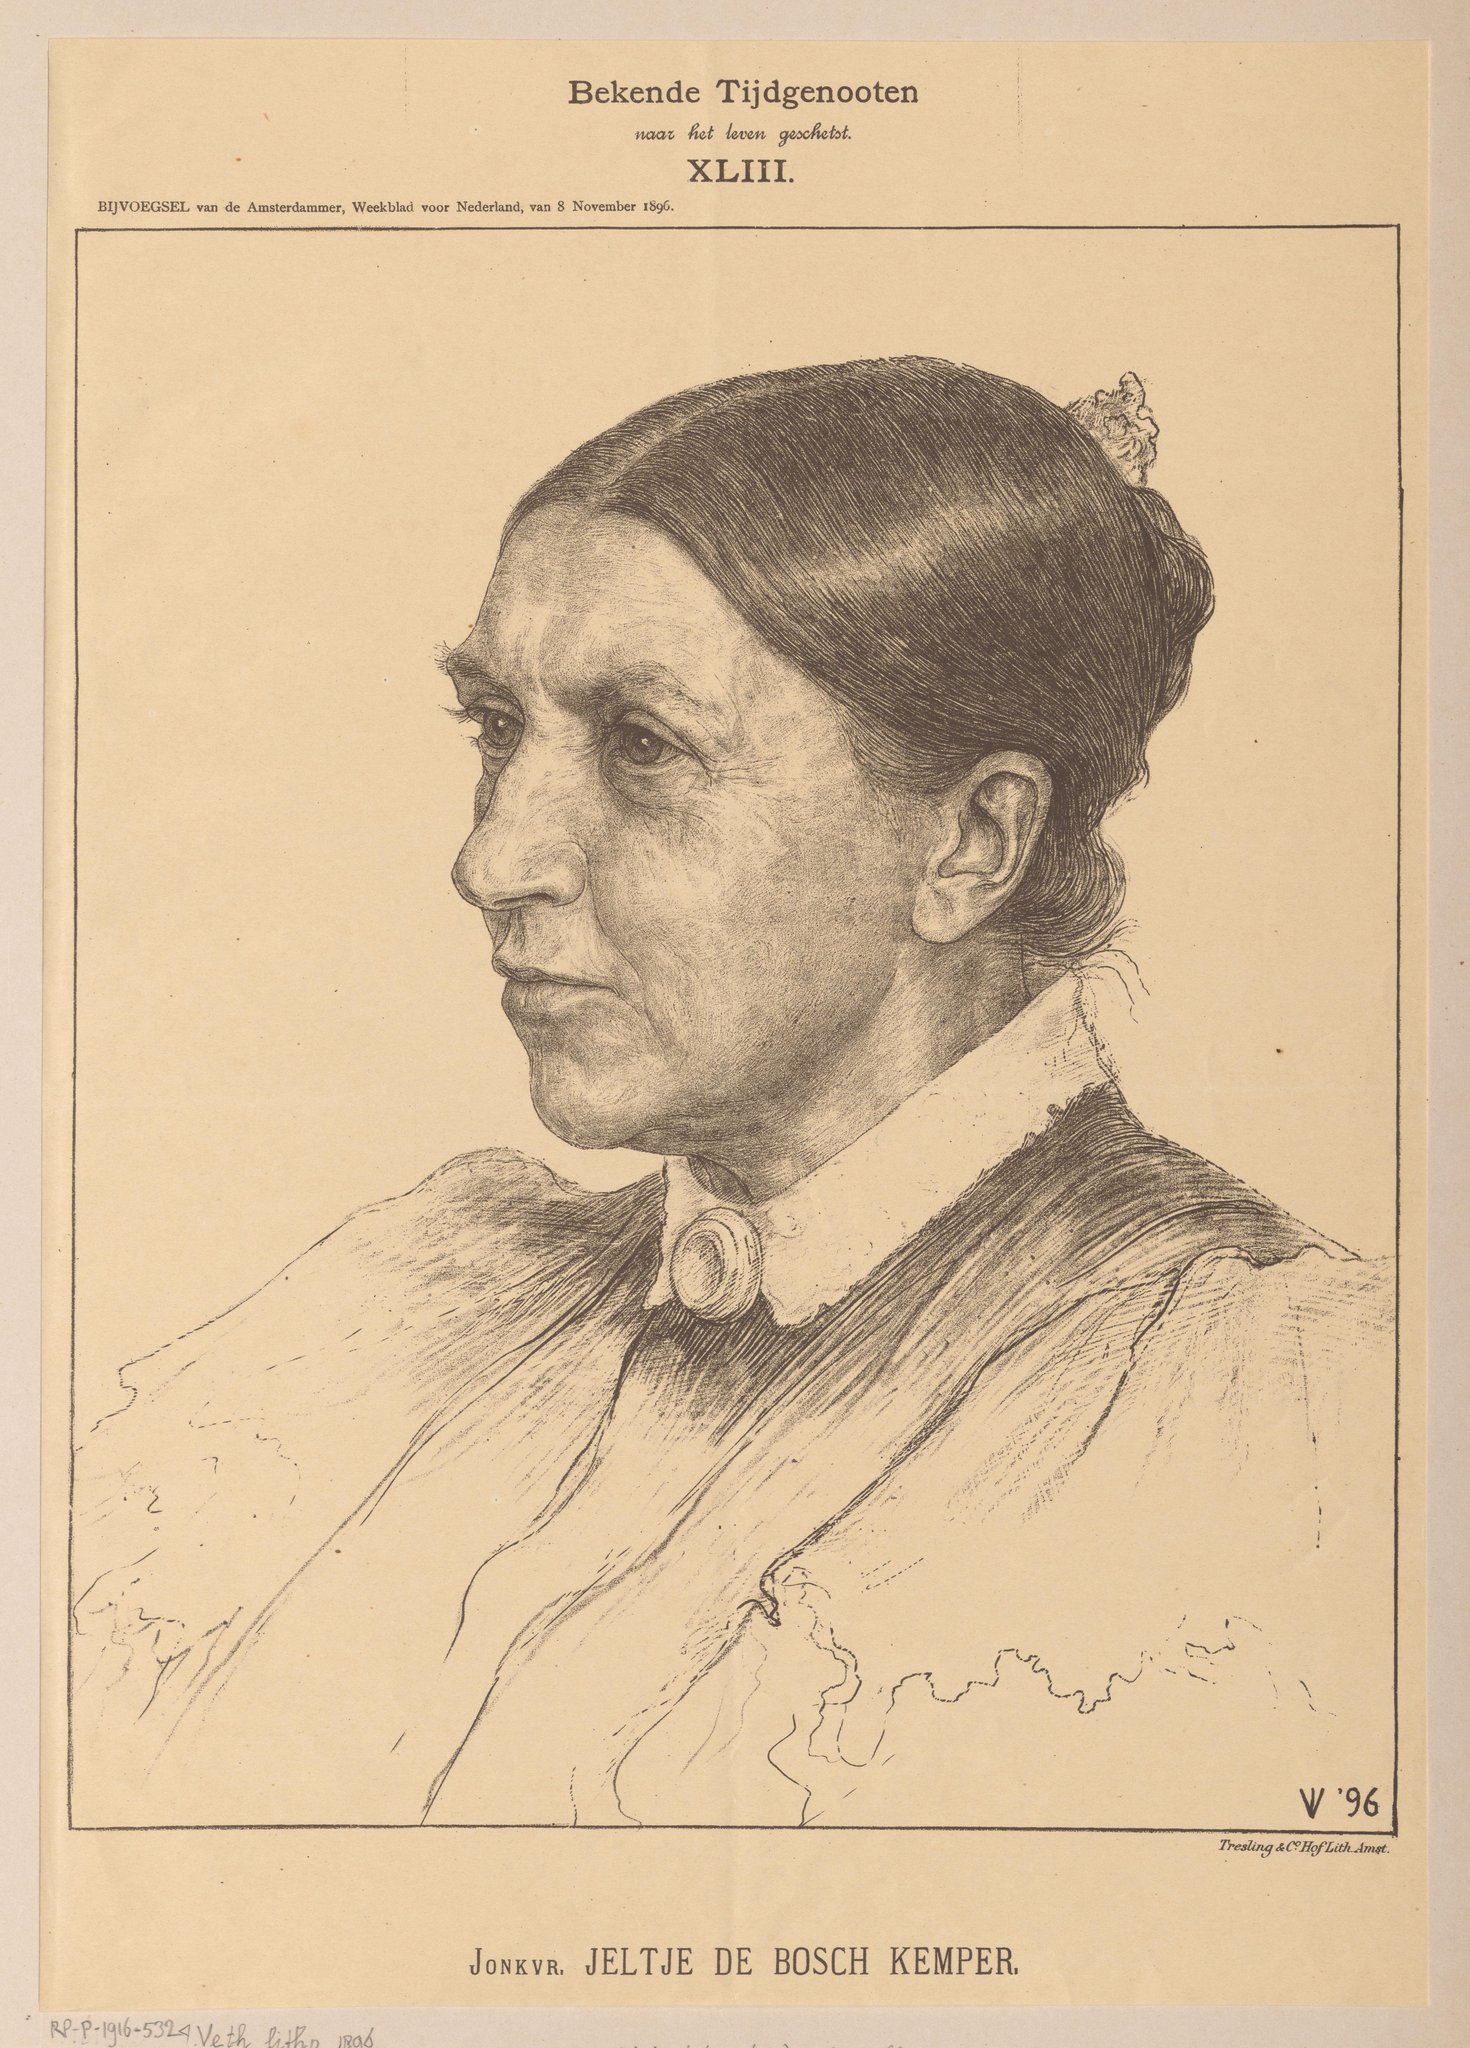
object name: print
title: Bekende tijdgenooten naar het leven geschetst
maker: jan veth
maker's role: designer, draughtsman, painter, print maker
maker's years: 1864-1925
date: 1896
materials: paper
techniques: lithograph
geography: amsterdam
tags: amsterdam, historical persons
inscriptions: collector's mark: Lugt 2228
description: Prent uit het bijvoegsel van: De Amsterdammer. Weekblad voor Nederland, 8 november 1896.